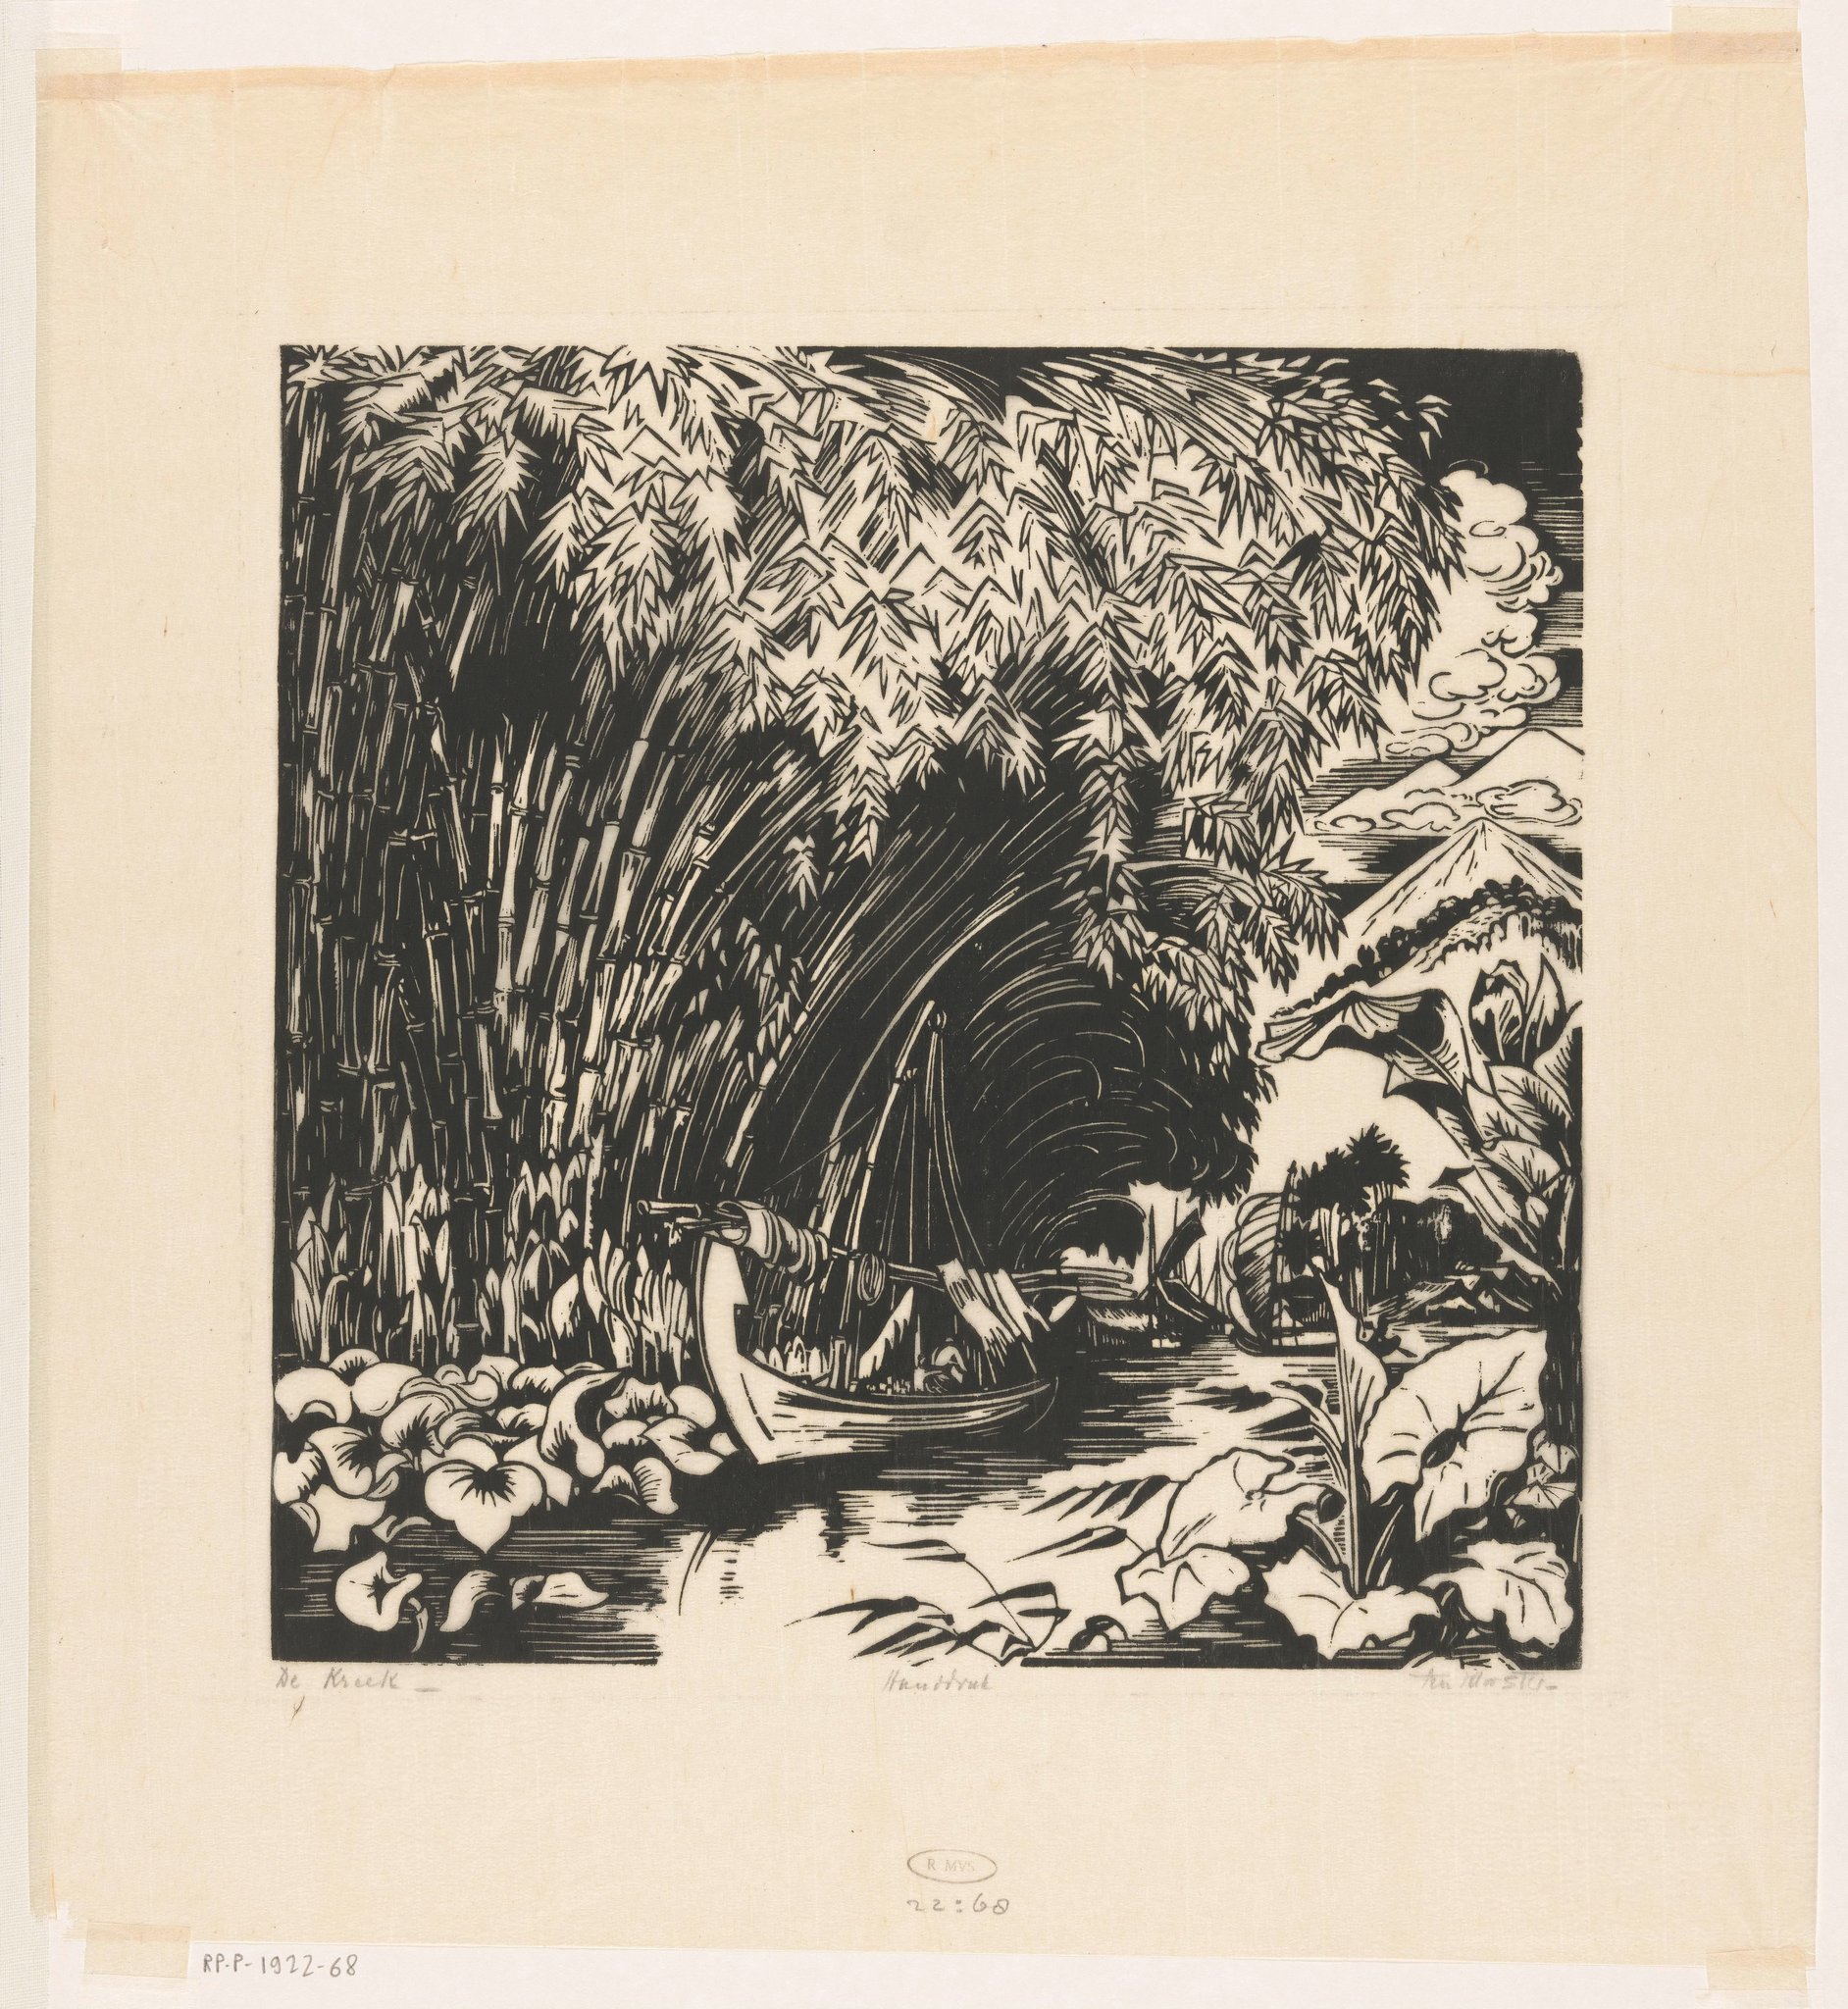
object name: print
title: De kreek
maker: johannes frederik engelbert ten klooster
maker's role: draughtsman, print maker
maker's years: 1873-1940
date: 1921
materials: paper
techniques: woodcut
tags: plants (in general), landscapes in tropical and sub-tropical regions, ships (in general)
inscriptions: collector's mark: Lugt 2228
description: Een vaart met zeilschepen. Links bamboe. Rechts op de achtergrond bergen.